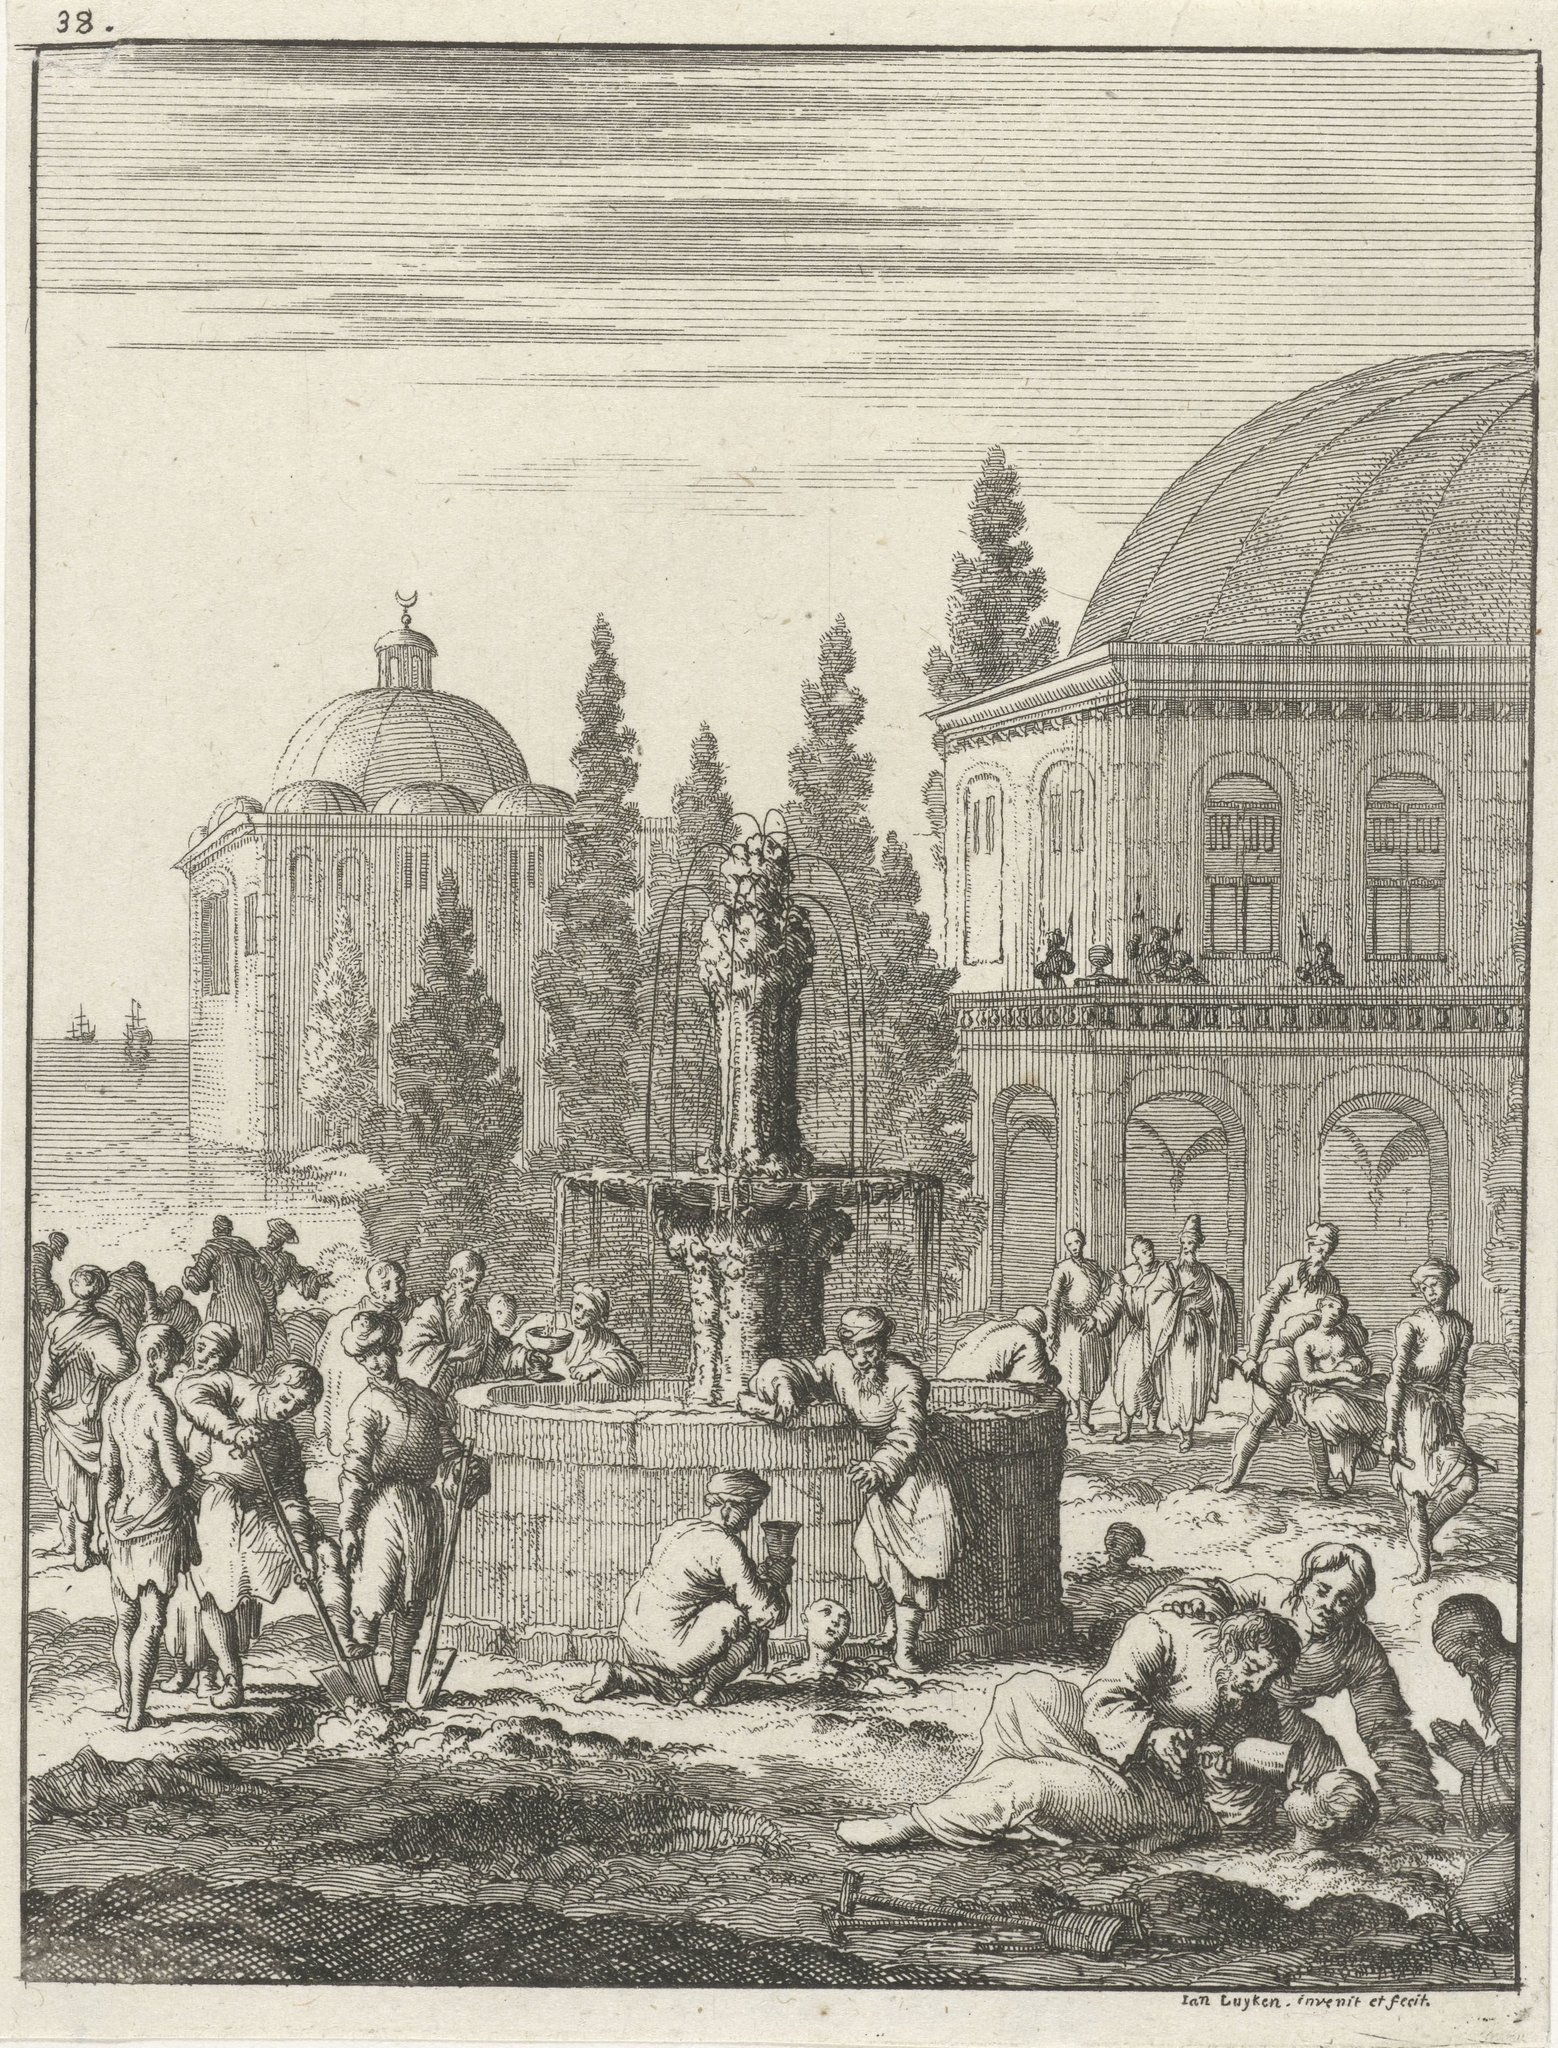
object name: book illustration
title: Heilzame fontein te Constantinopel waar de zieken in de bodem worden begraven en gedrenkt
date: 1681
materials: paper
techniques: etching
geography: amsterdam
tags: magic healings, ornamental fountain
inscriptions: collector's mark: Lugt 2228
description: Illustratie opgenomen in deel I van: Thevenot, Jean de. Gedenkwaardige en zeer naauwkeurige reizen van den heere de Thevenot. Amsterdam: Jan Bouman, 1681-1682.